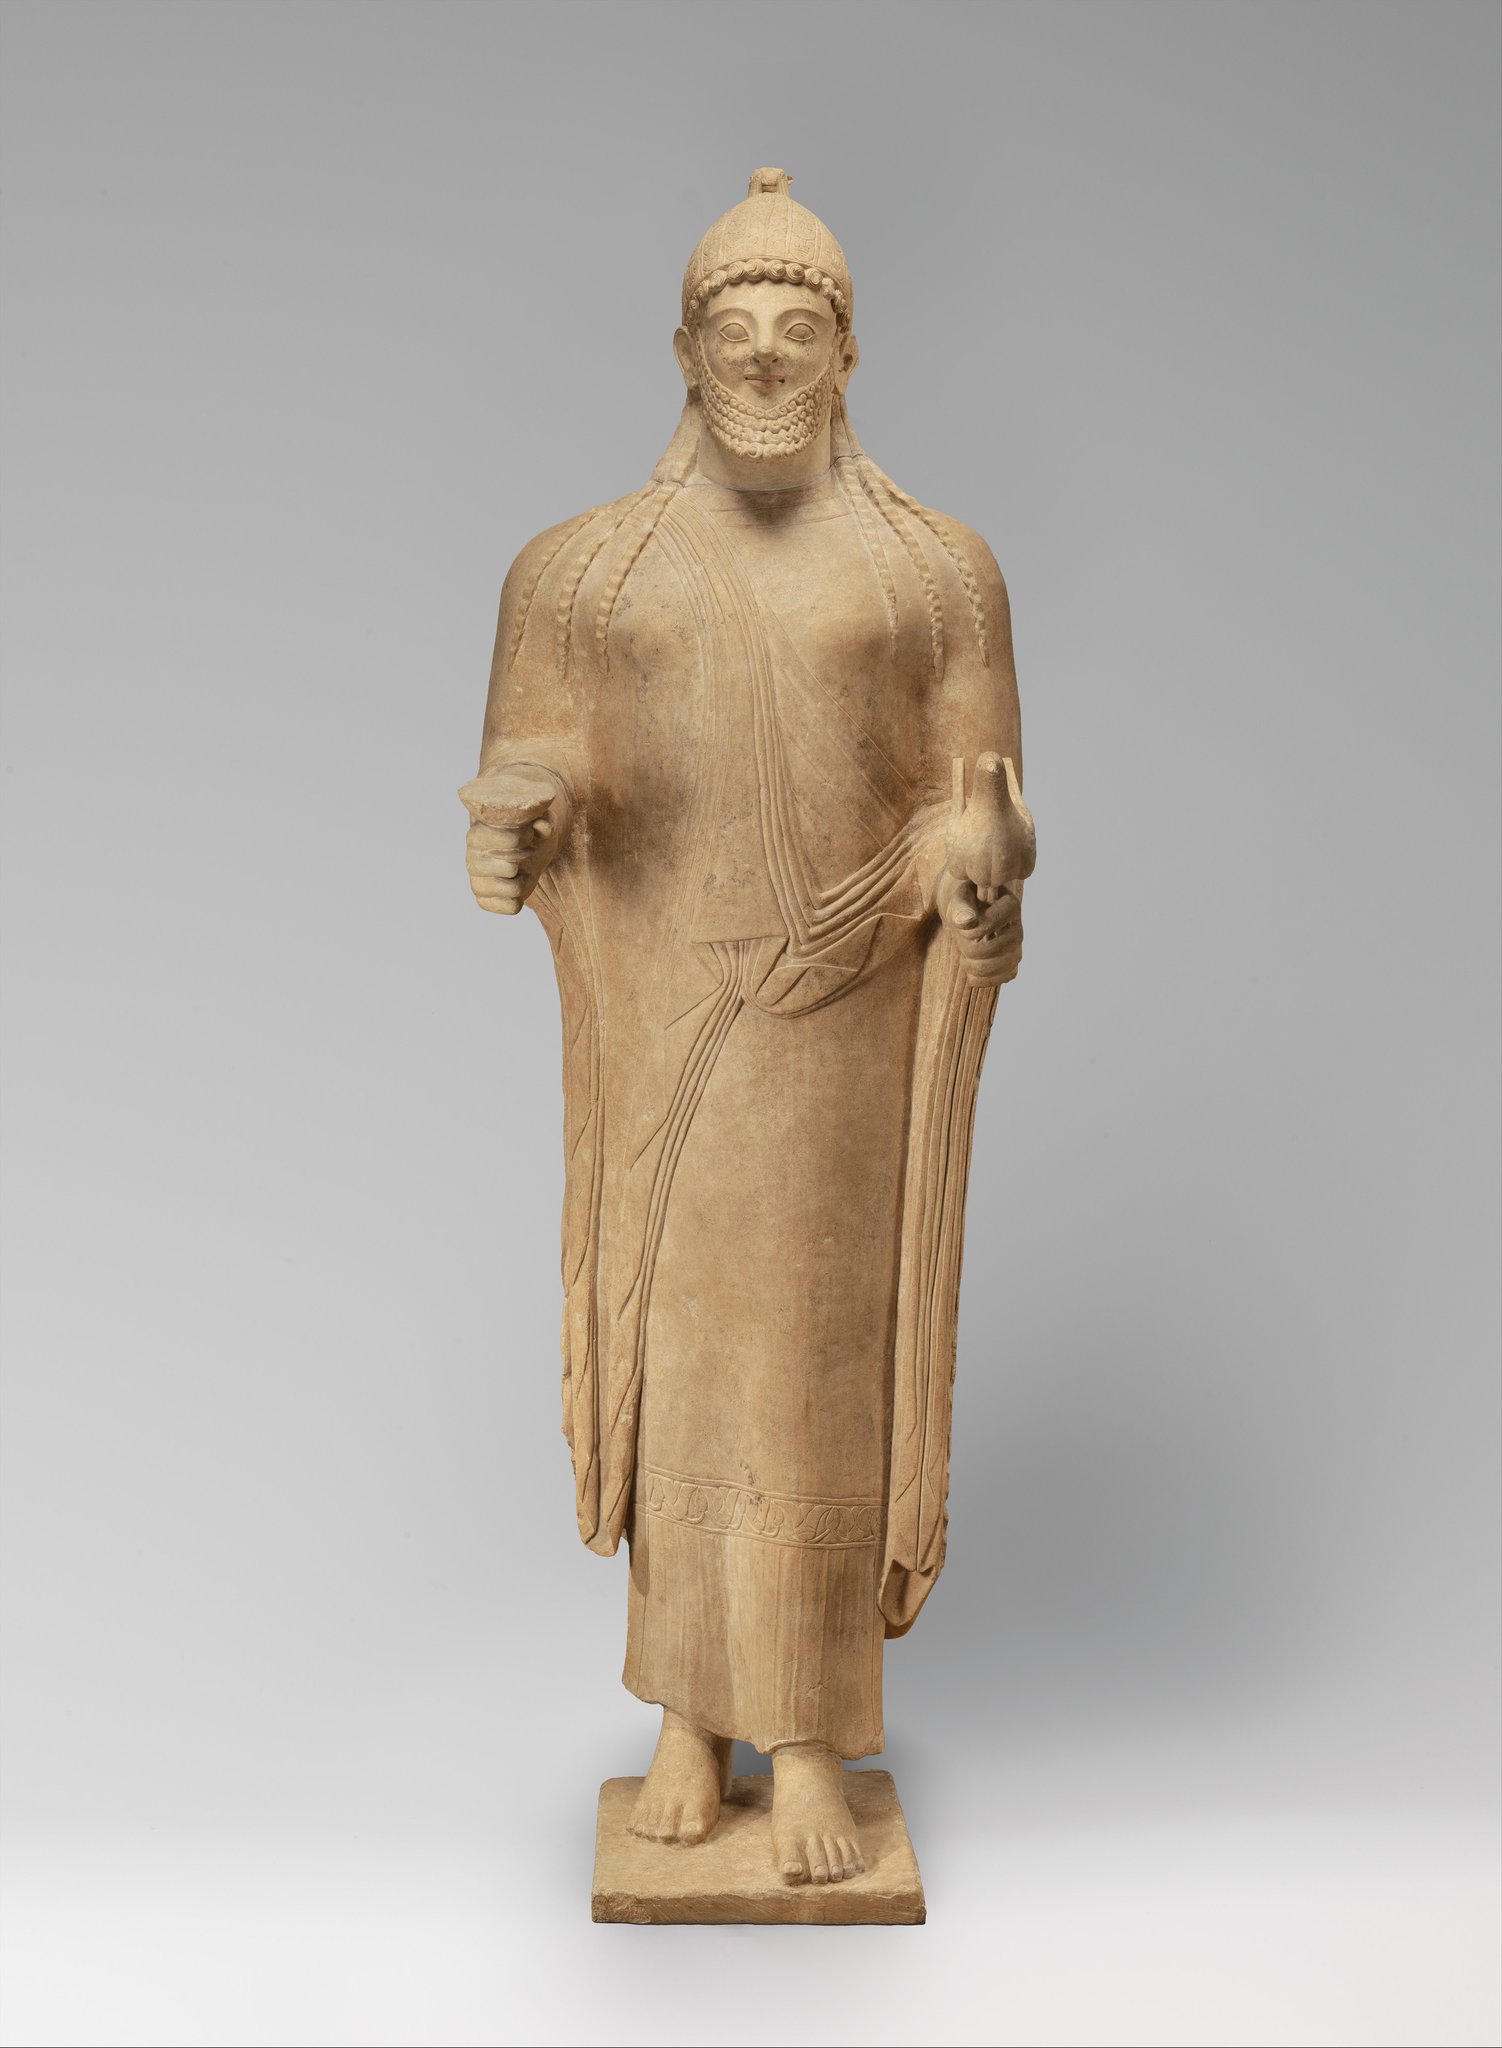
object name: statue of a priest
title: Limestone priest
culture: cypriot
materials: limestone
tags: birds,men